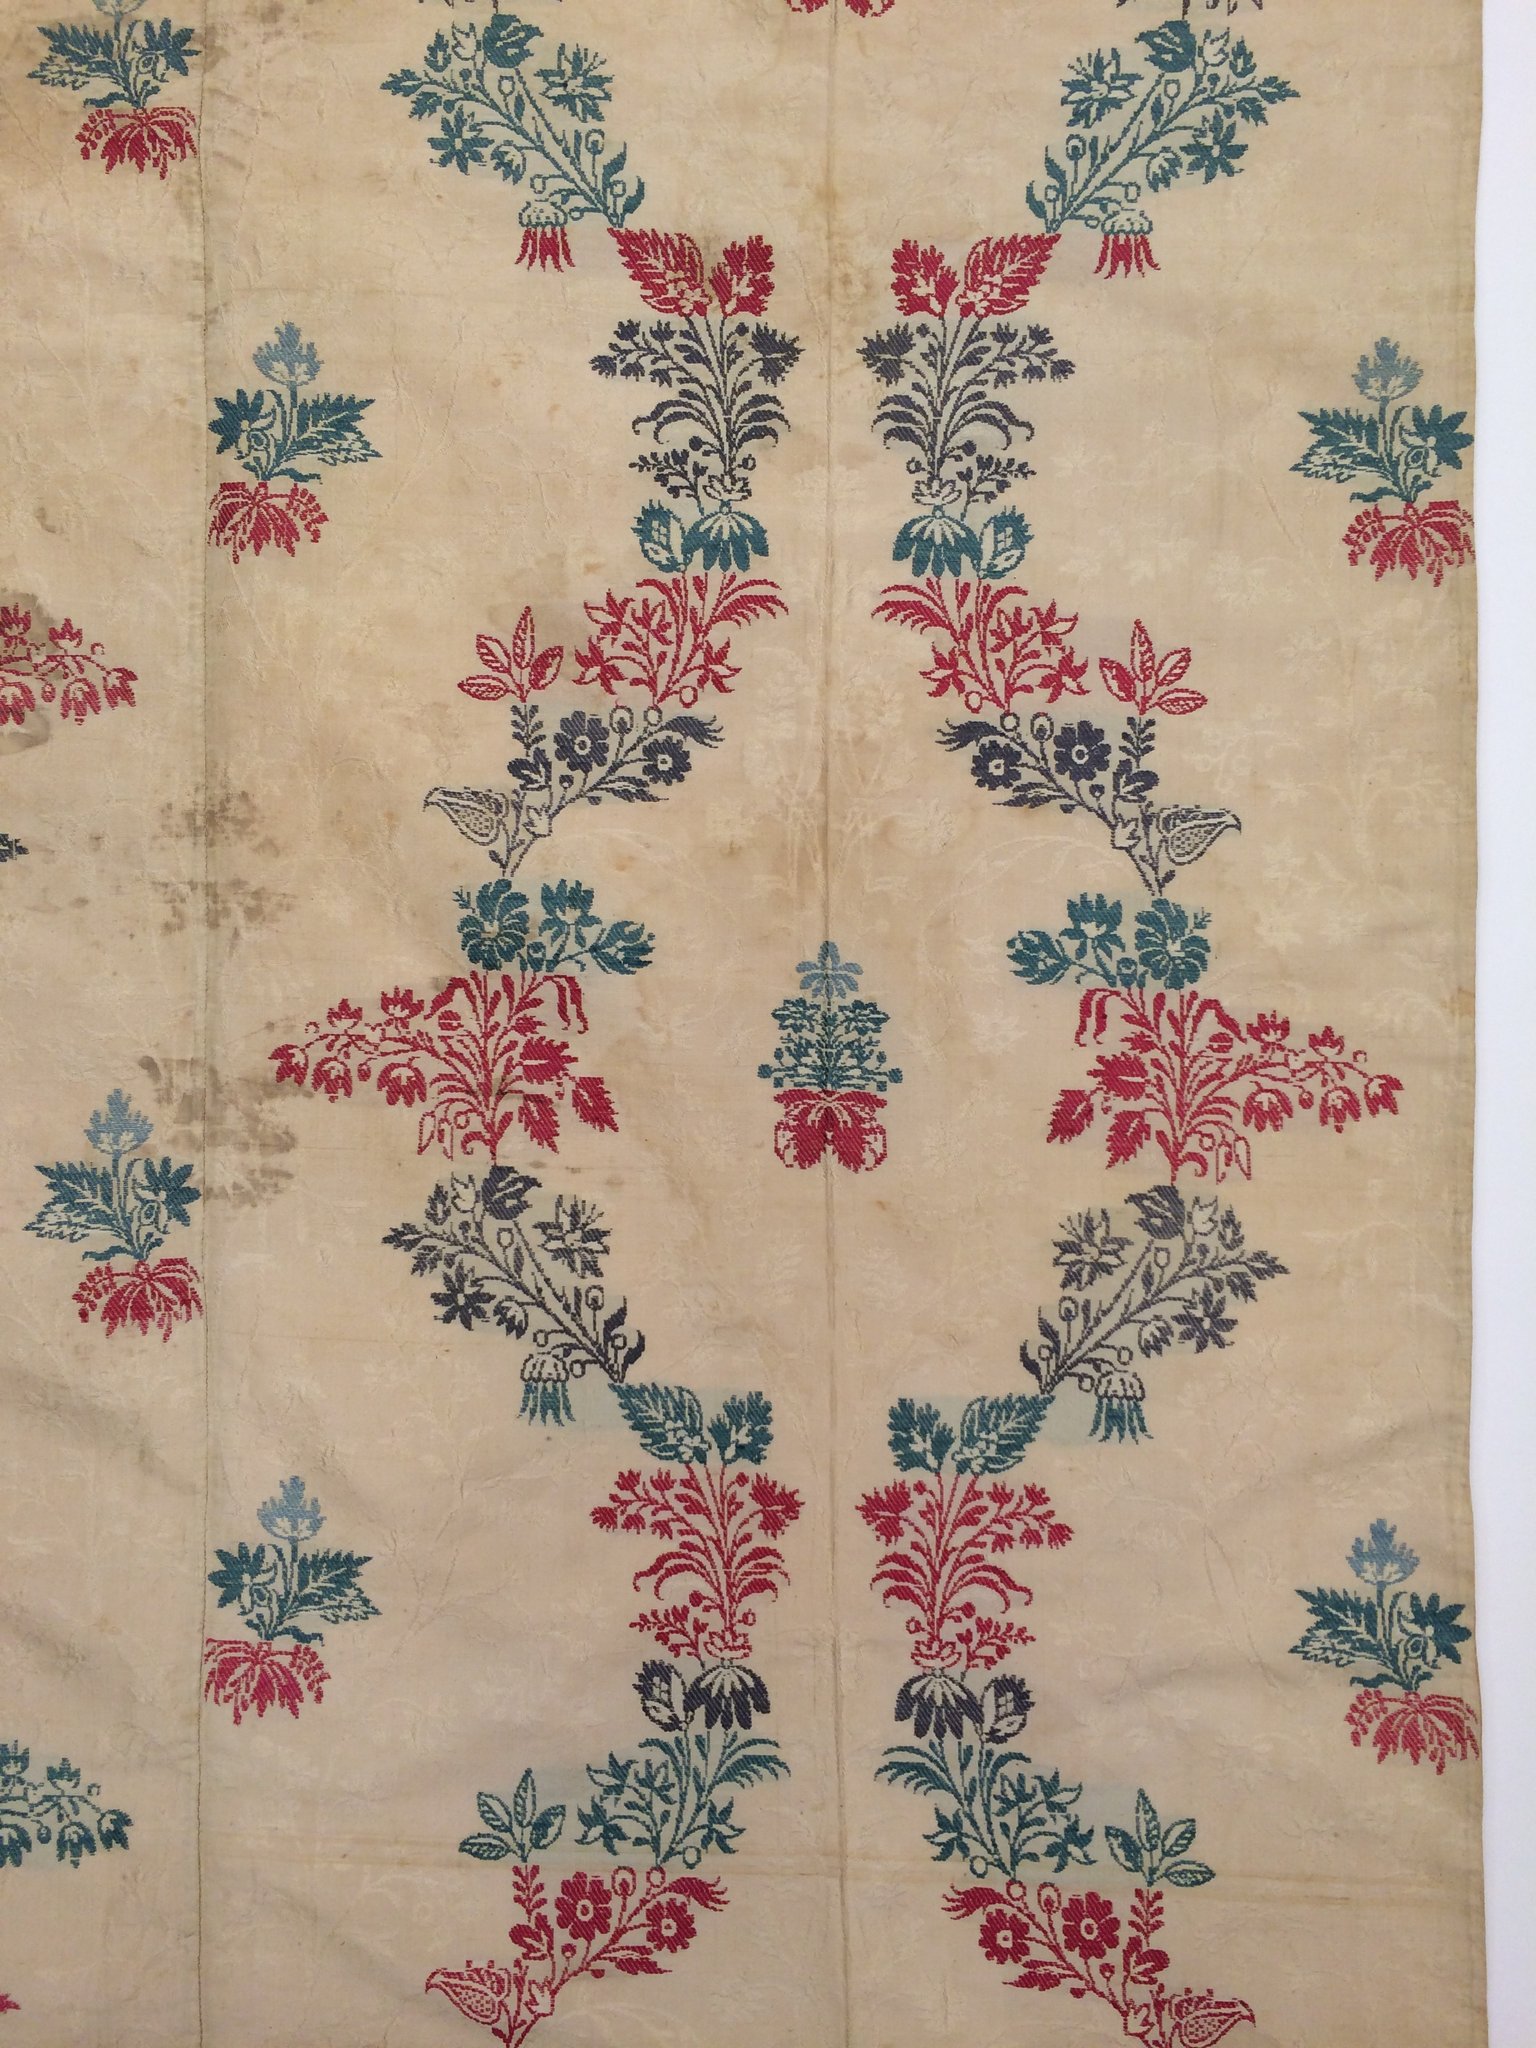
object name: christening blanket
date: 1725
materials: silk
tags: flowers